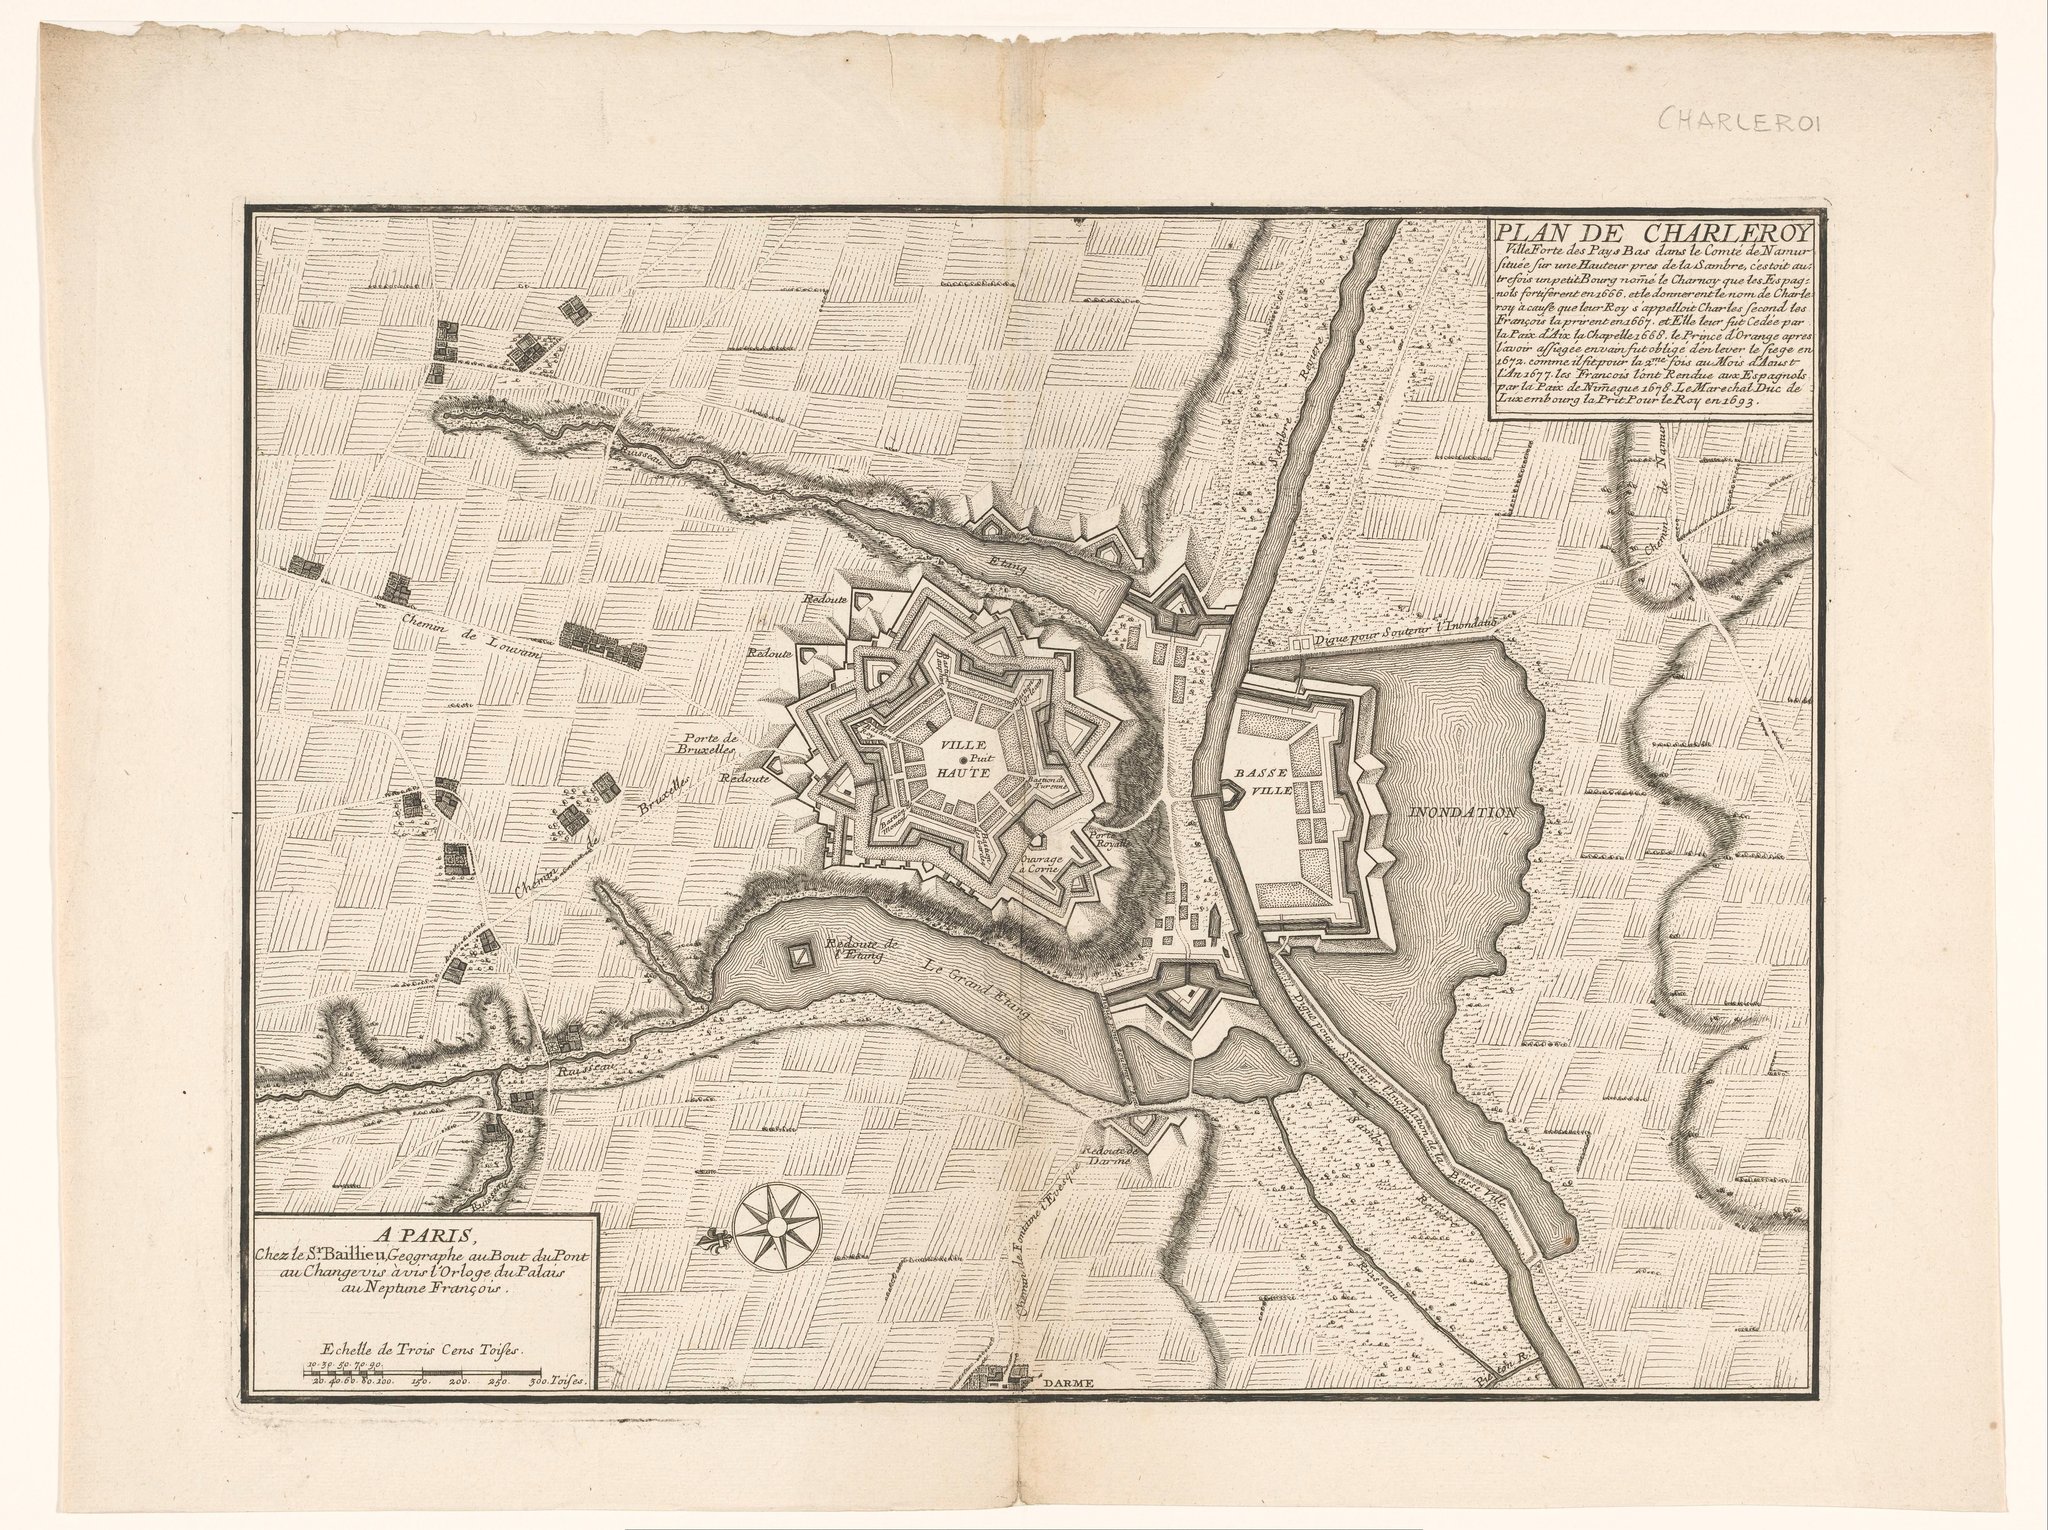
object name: area plan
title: Vestingplattegrond van Charleroi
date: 1693-1744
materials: paper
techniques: engraving, etching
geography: paris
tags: fortified city, maps of cities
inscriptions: collector's mark: Lugt 2228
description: Vestingplattegrond van Charleroi. Rechtsboven een kader met titel. Linksonder een kader met schaalstok: Echelle de Trois Cens Toises.